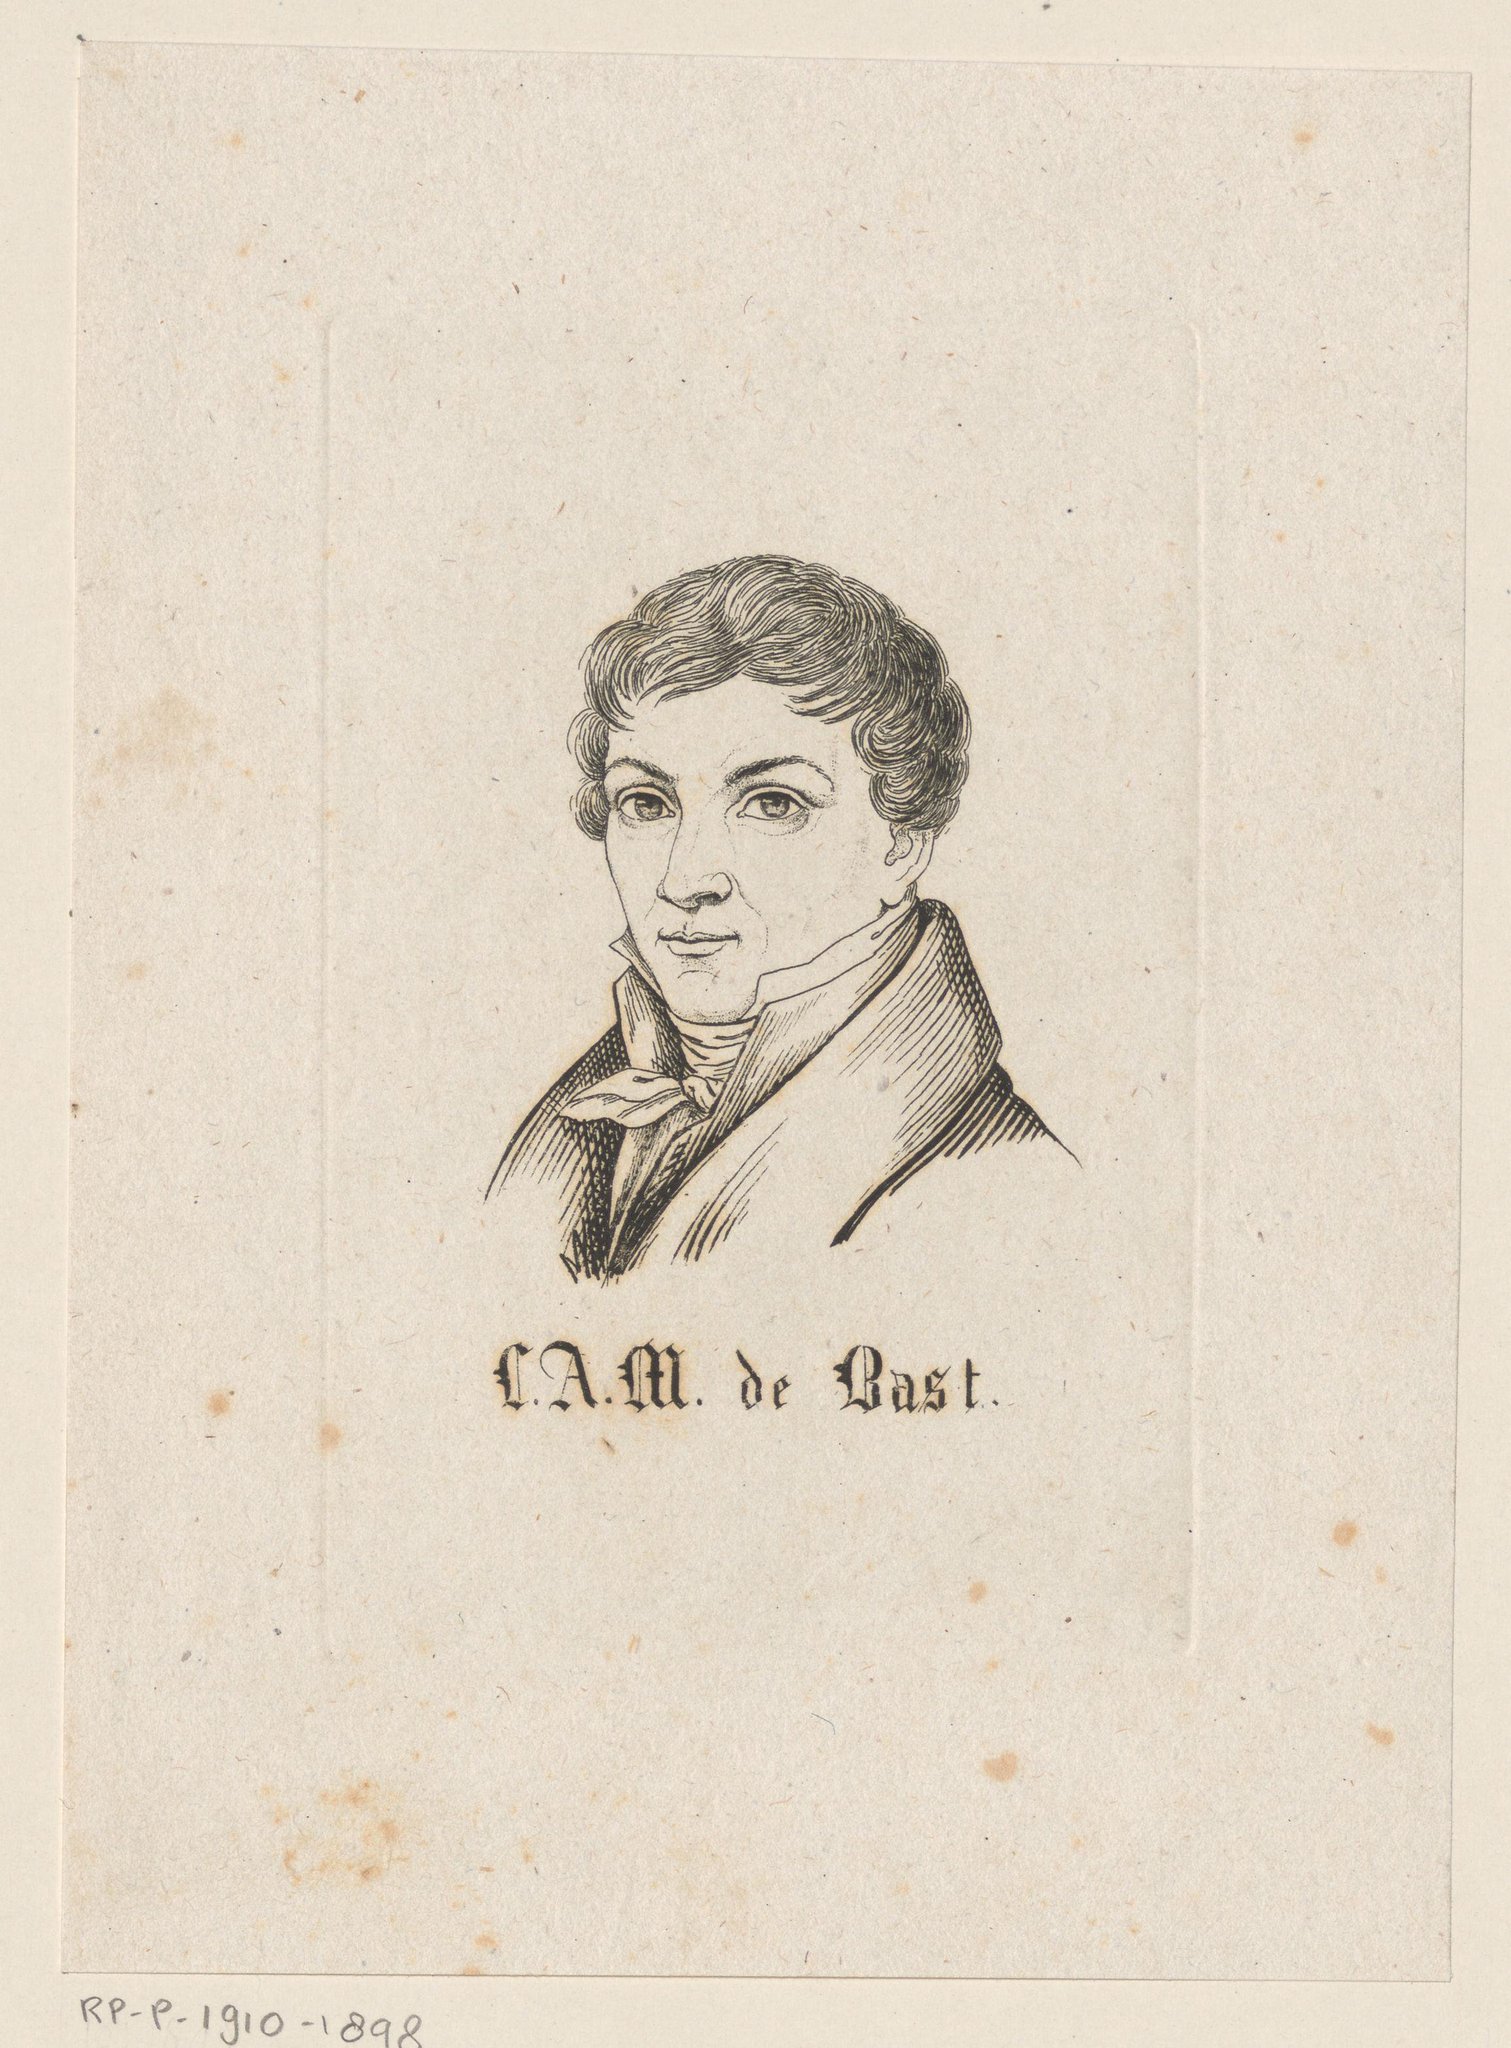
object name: print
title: Portret van Liévin Amand Marie De Bast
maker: Anonymous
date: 1800-1849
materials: paper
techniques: etching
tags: print maker, liévin amand marie de bast, historical persons, portrait, self-portrait of artist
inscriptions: collector's mark: Lugt 2228